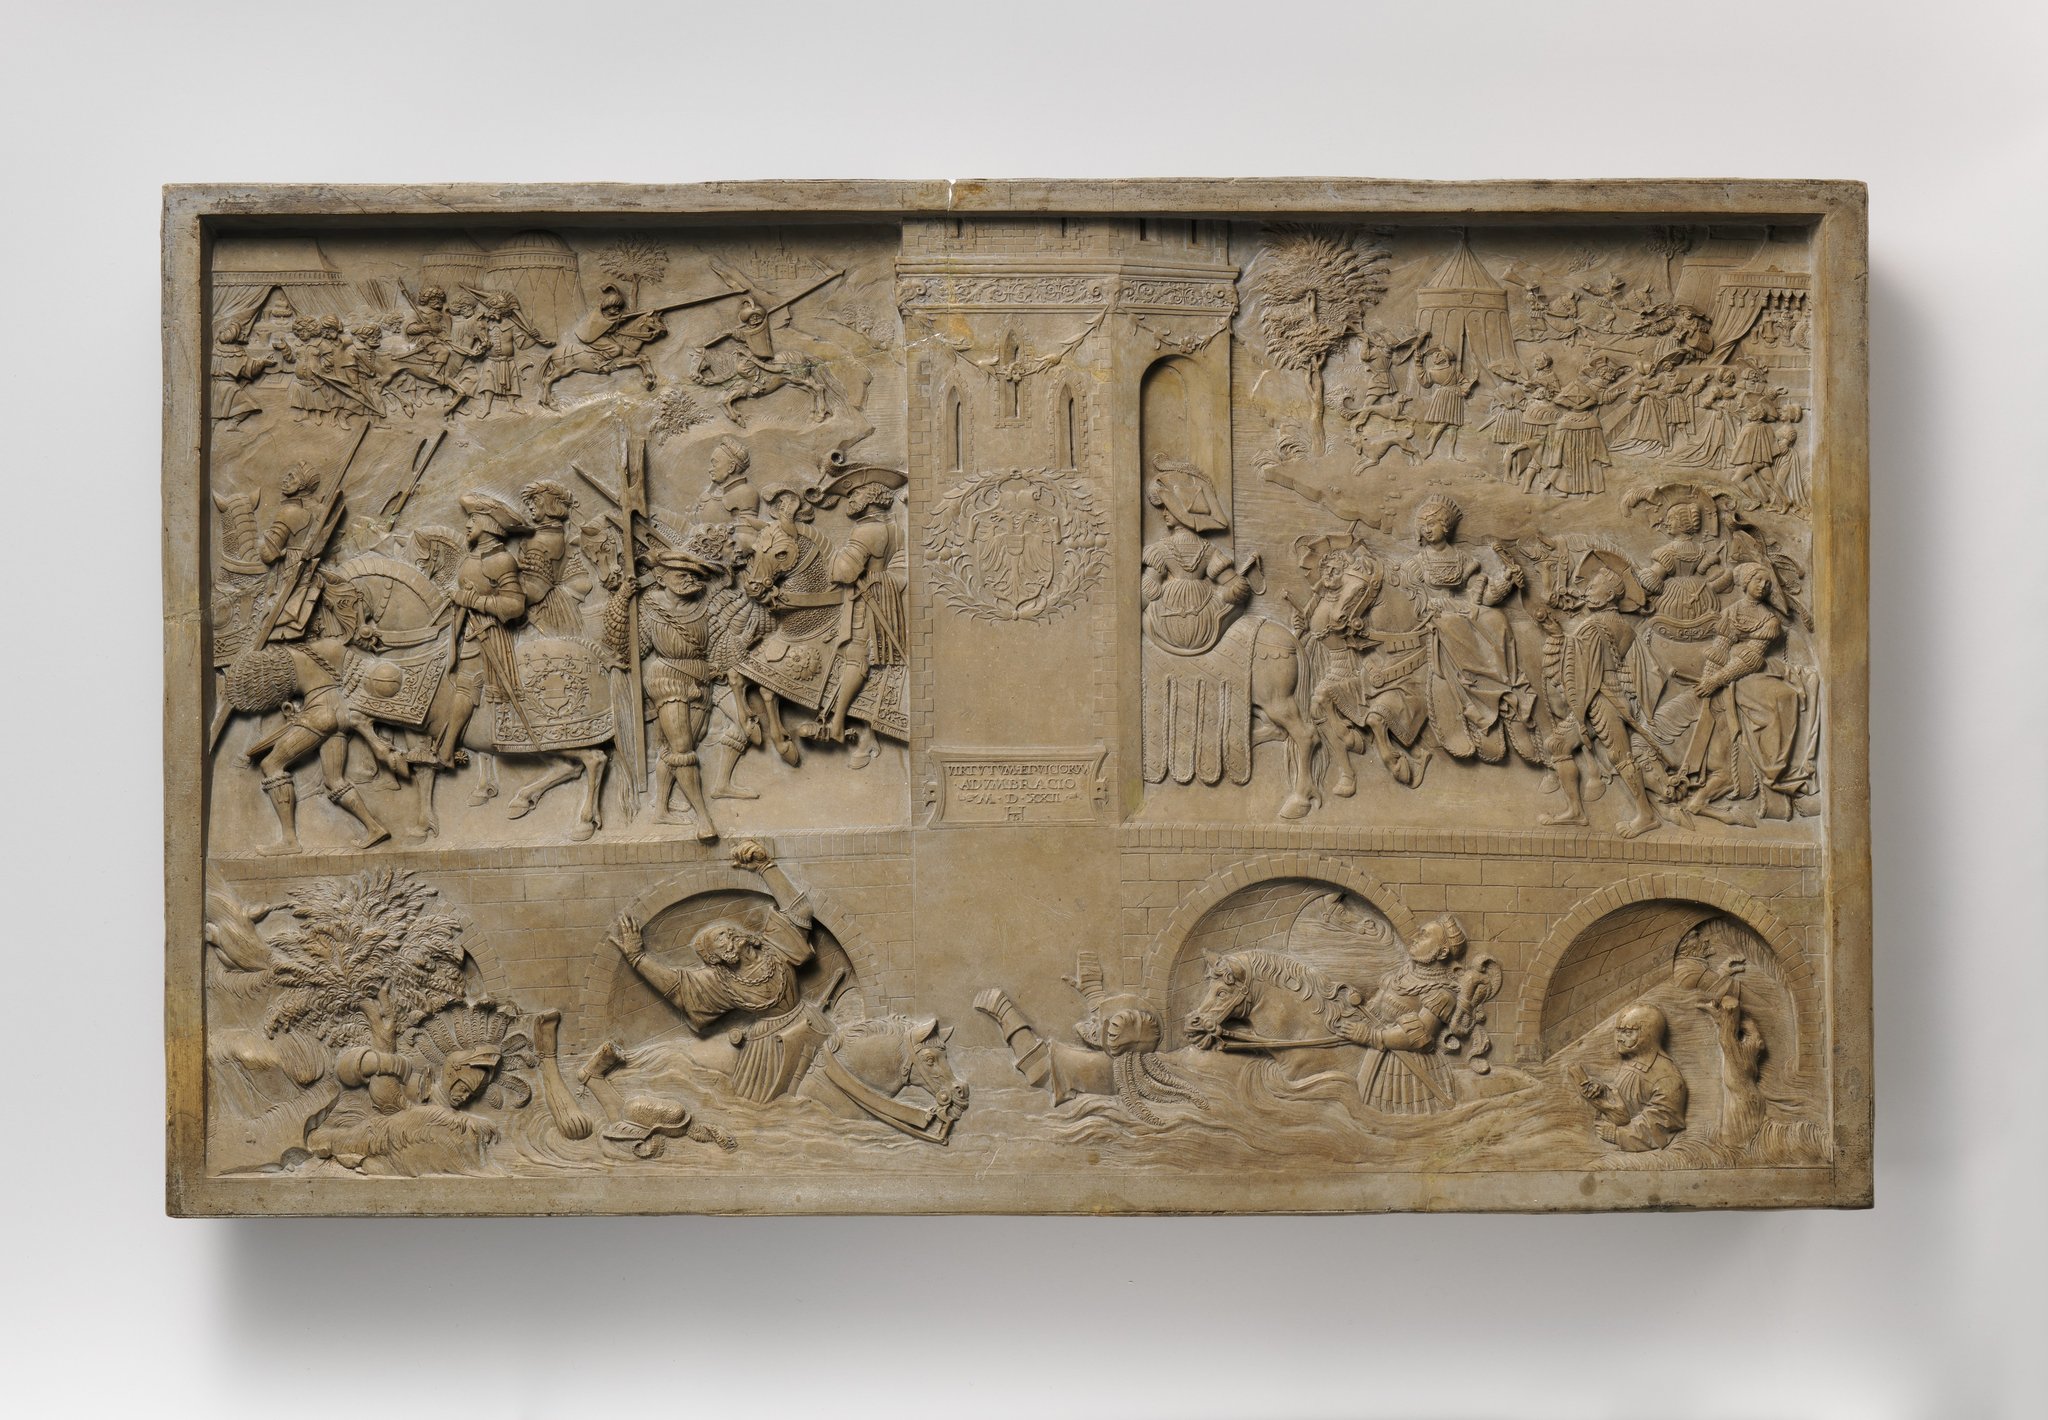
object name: relief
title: Allegory of Virtues and Vices at the Court of Charles V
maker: hans daucher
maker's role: artist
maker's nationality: german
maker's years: 1480-1538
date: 1522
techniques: gilding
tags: tents,men,women,horses,processions